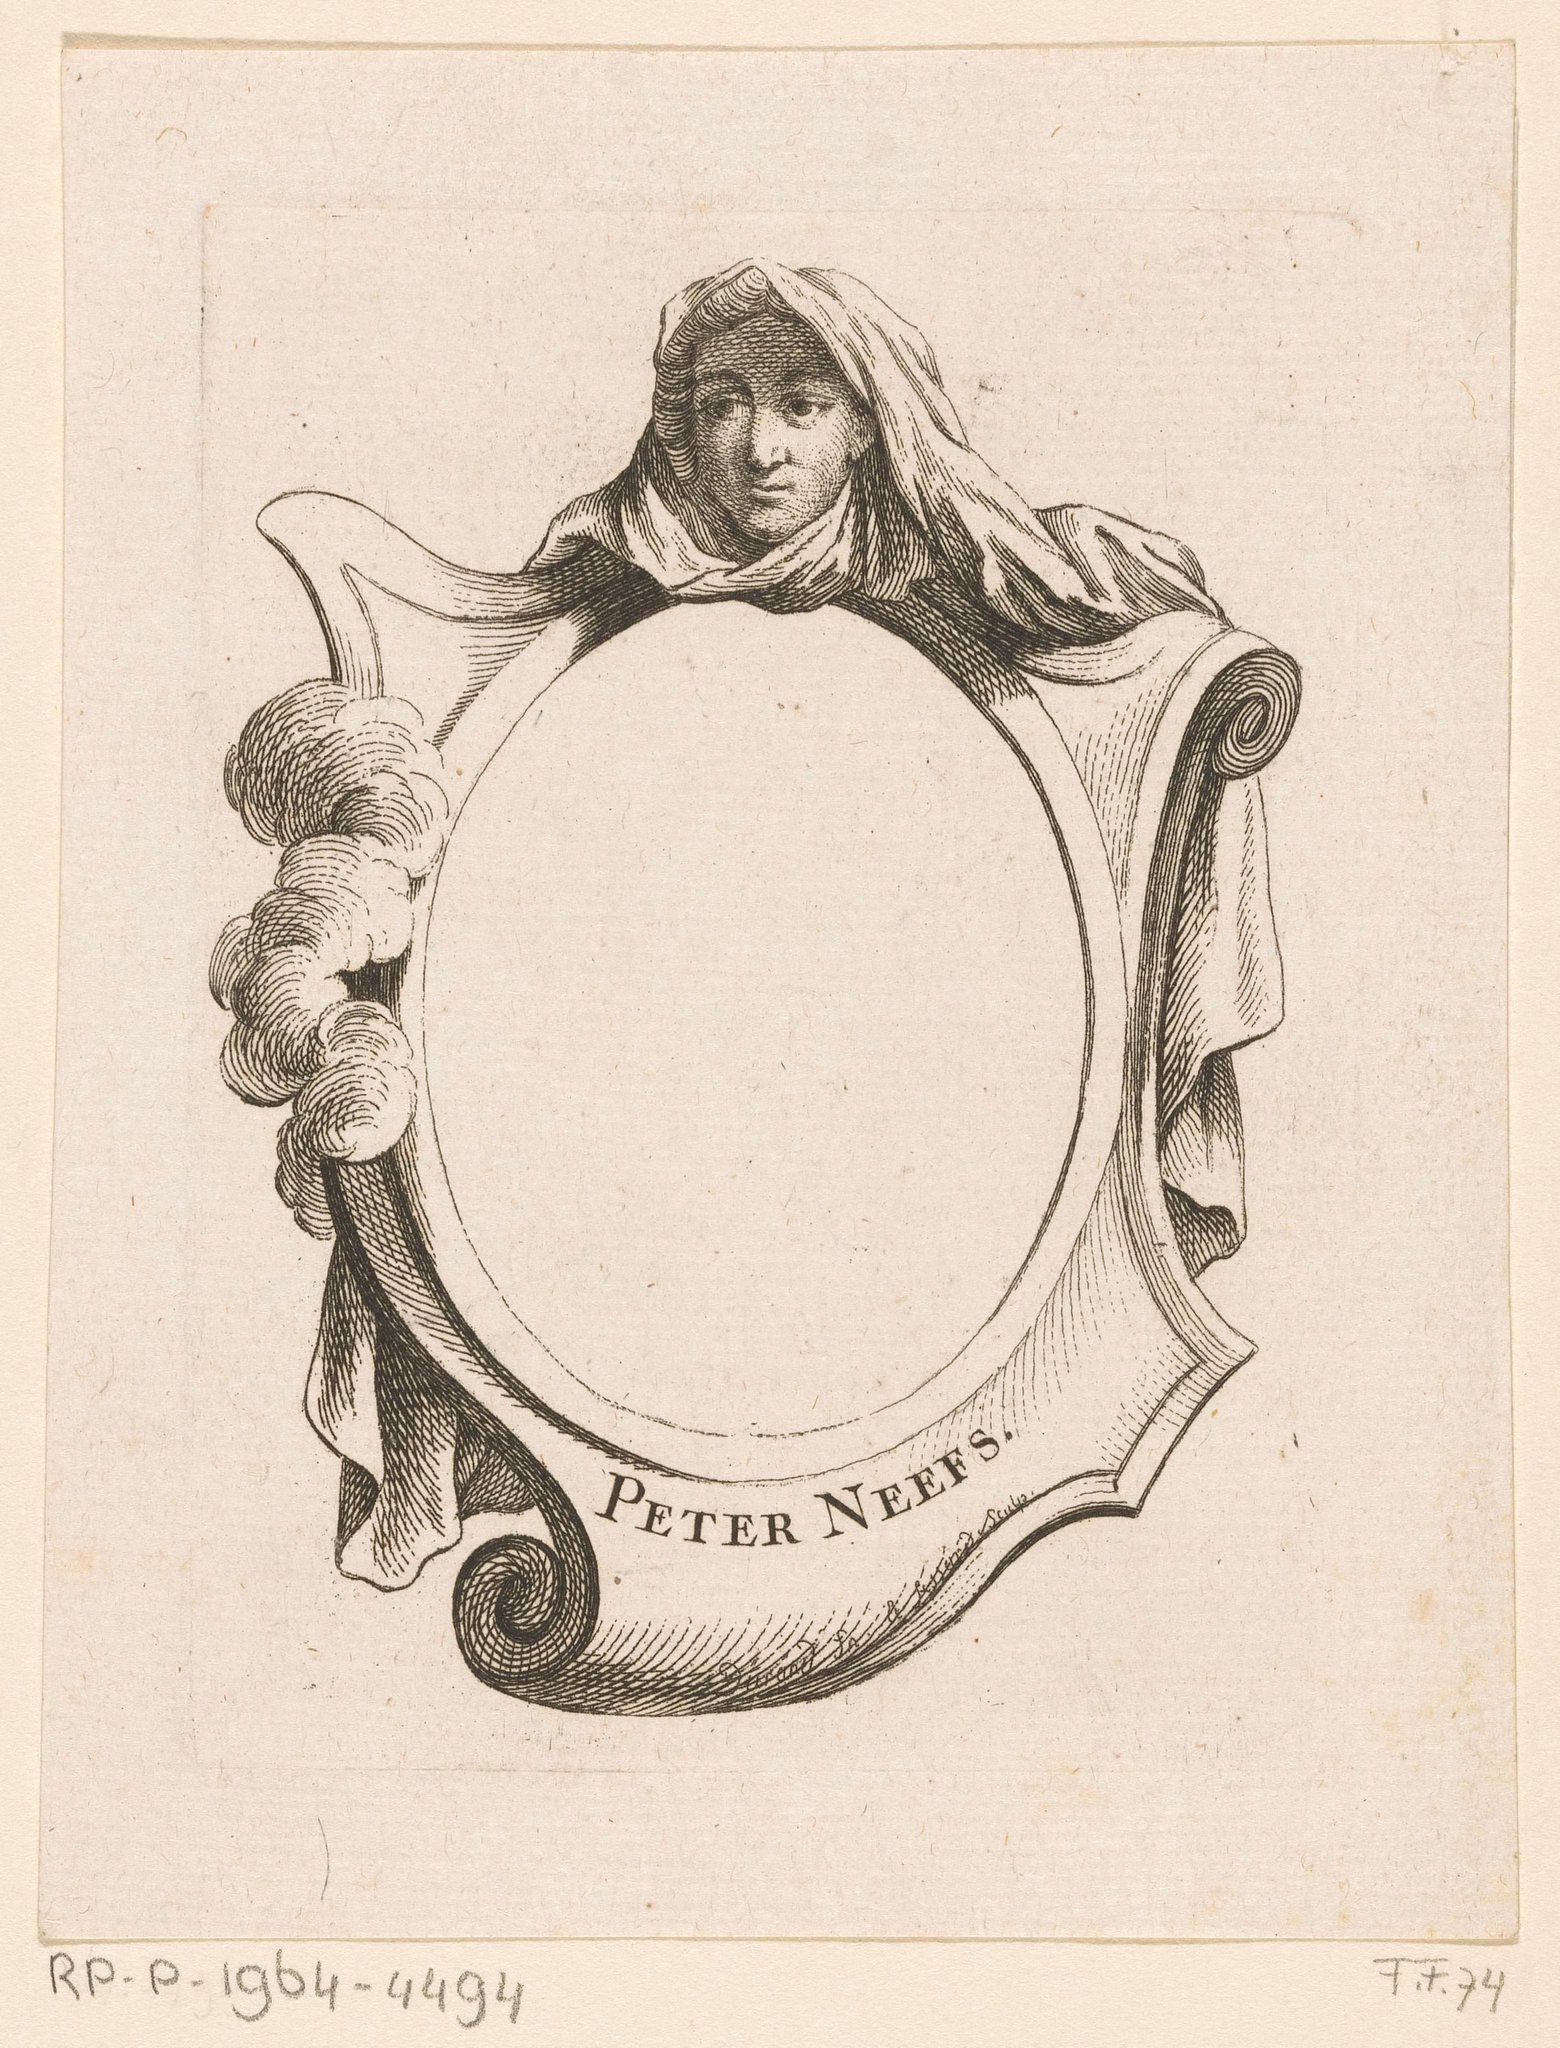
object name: ornament print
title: Omlijstingen voor kunstenaarsportretten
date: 1724-1777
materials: paper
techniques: etching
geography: france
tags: ornaments ~ art (+ framing decorations), artist (in general)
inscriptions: collector's mark: Lugt 2760, collector's mark: Lugt 2228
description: Een ovale omlijsting met een gezicht met sluier en een rookpluim voor Peter Neefs (Pieter Neefs).